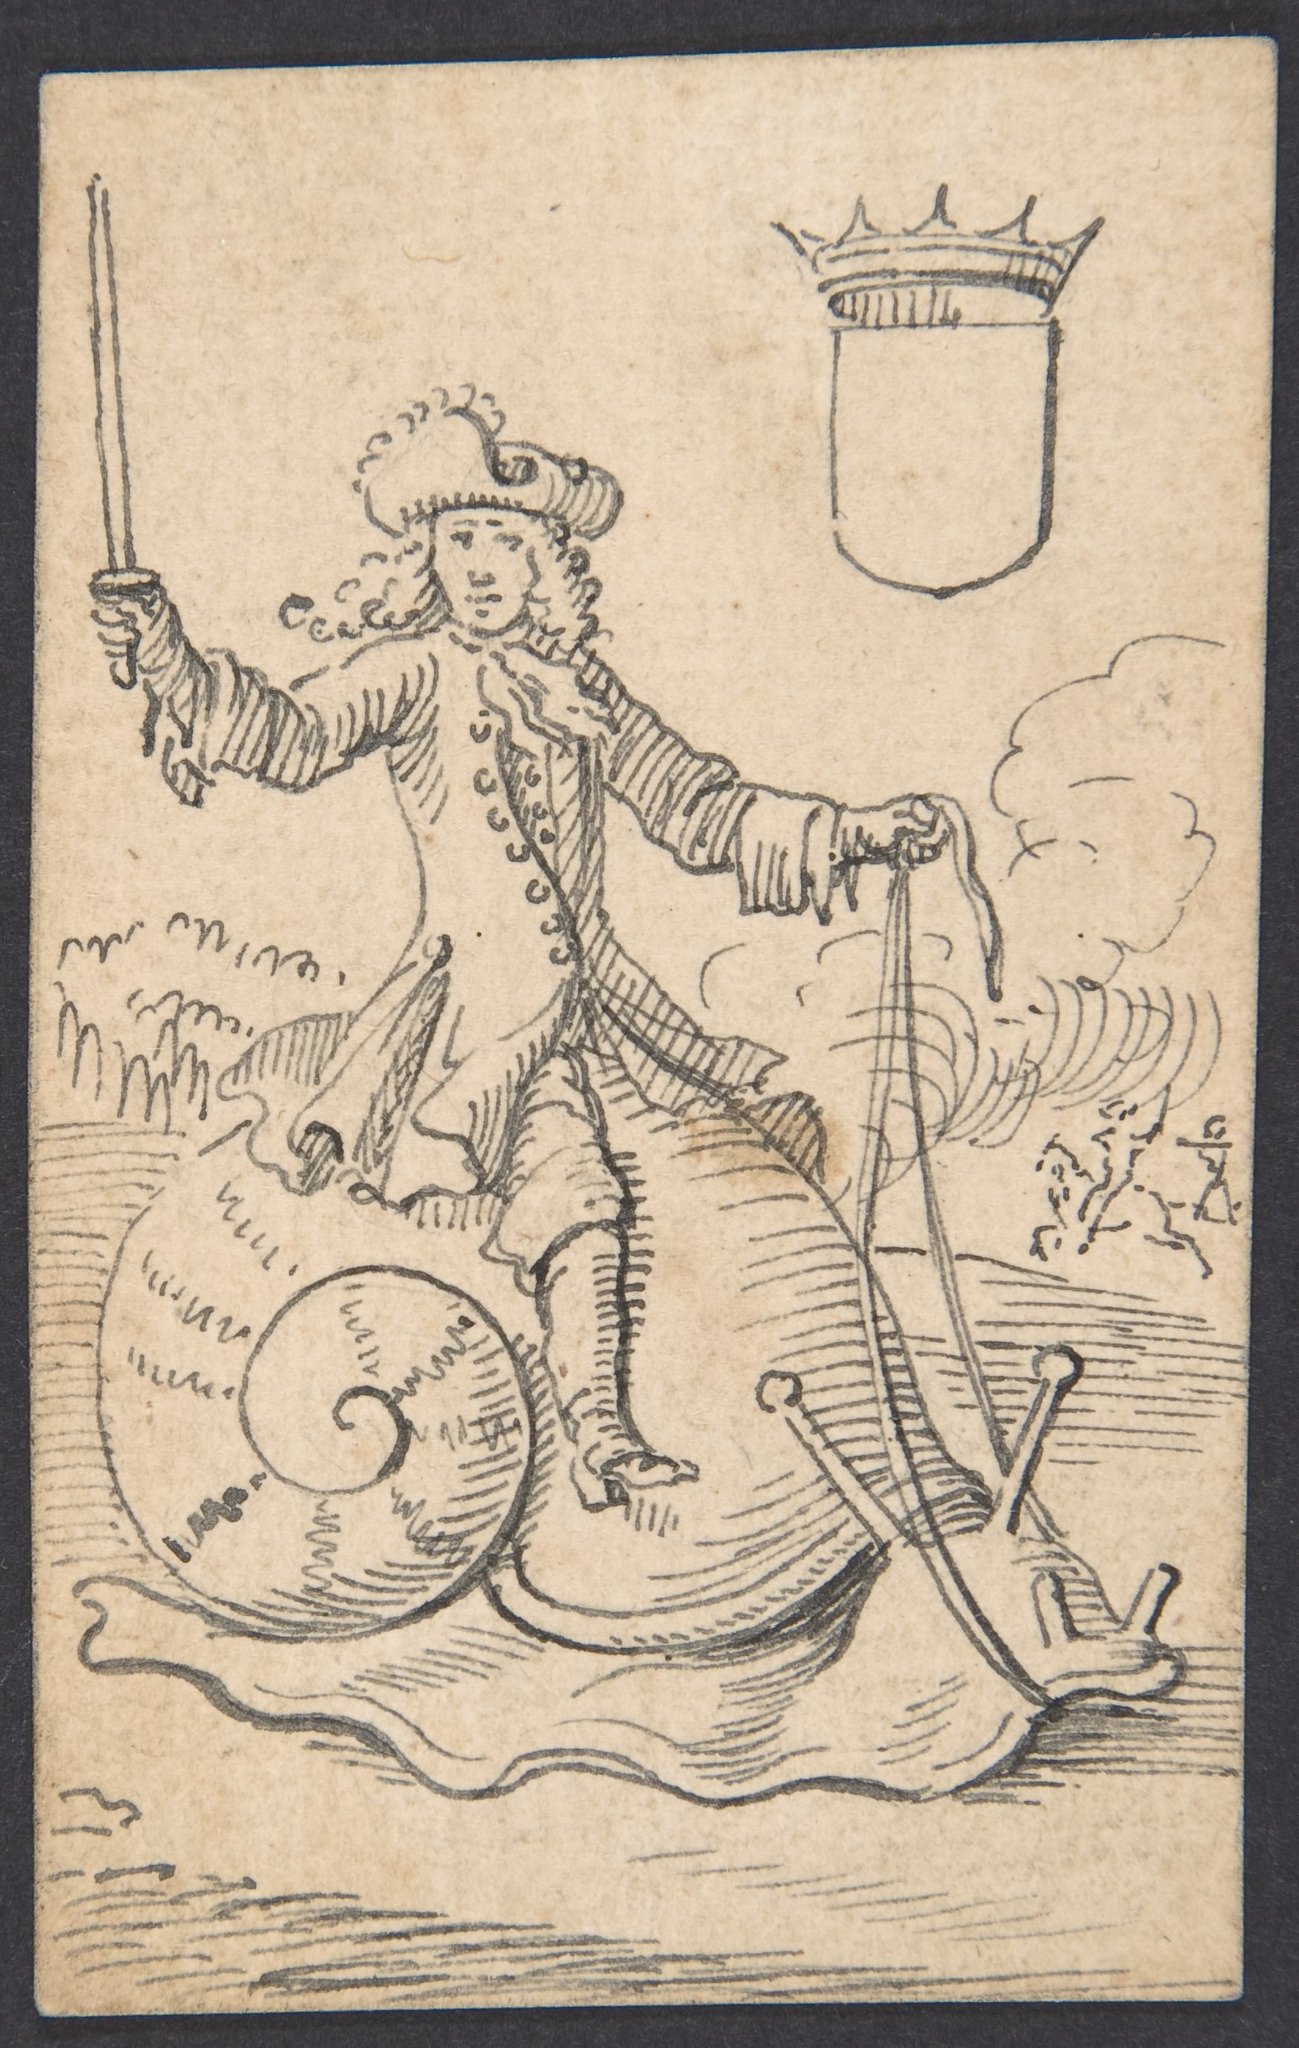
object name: drawing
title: Shield King: A Man Astride a Snail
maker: johannes brandenberg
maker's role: artist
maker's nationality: swiss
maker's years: 1661-1729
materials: ink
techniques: pen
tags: swords,men,snails